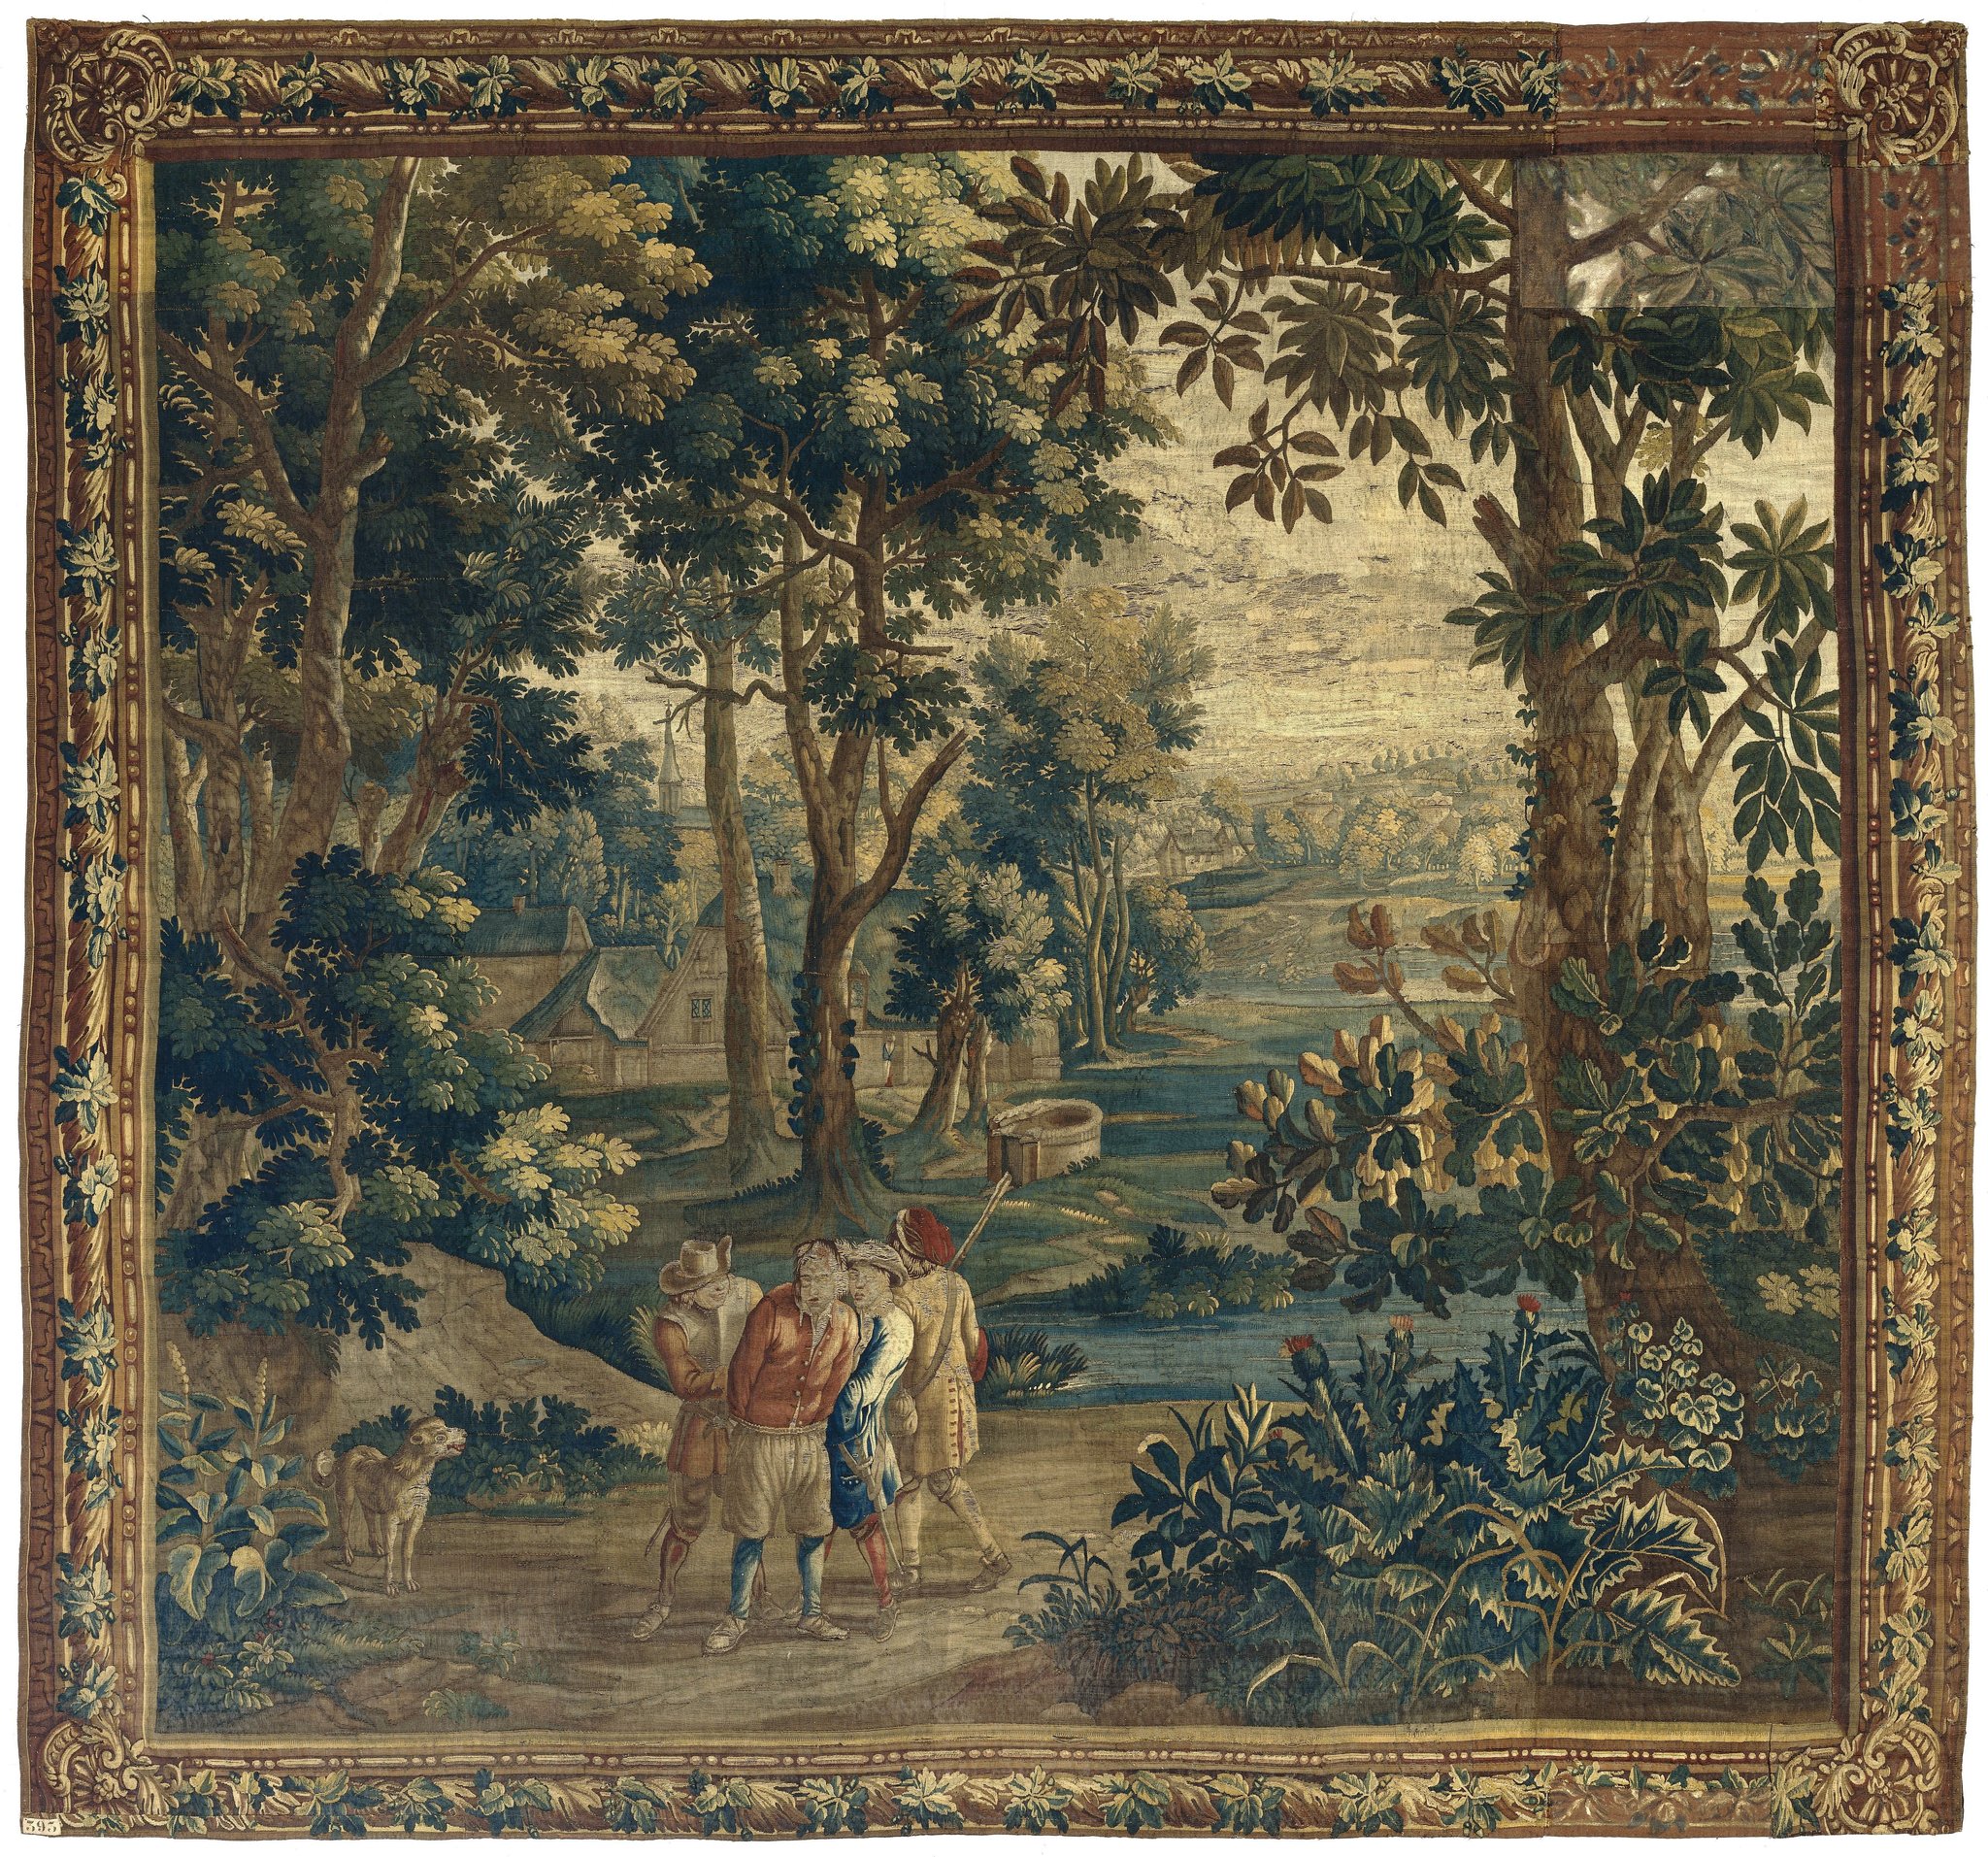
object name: tapestry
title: Het volksleven naar Teniers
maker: Anonymous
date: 1700-1725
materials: silk, wool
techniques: tapestry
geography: southern netherlands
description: Wandtapijt met de aanhouding van een man.